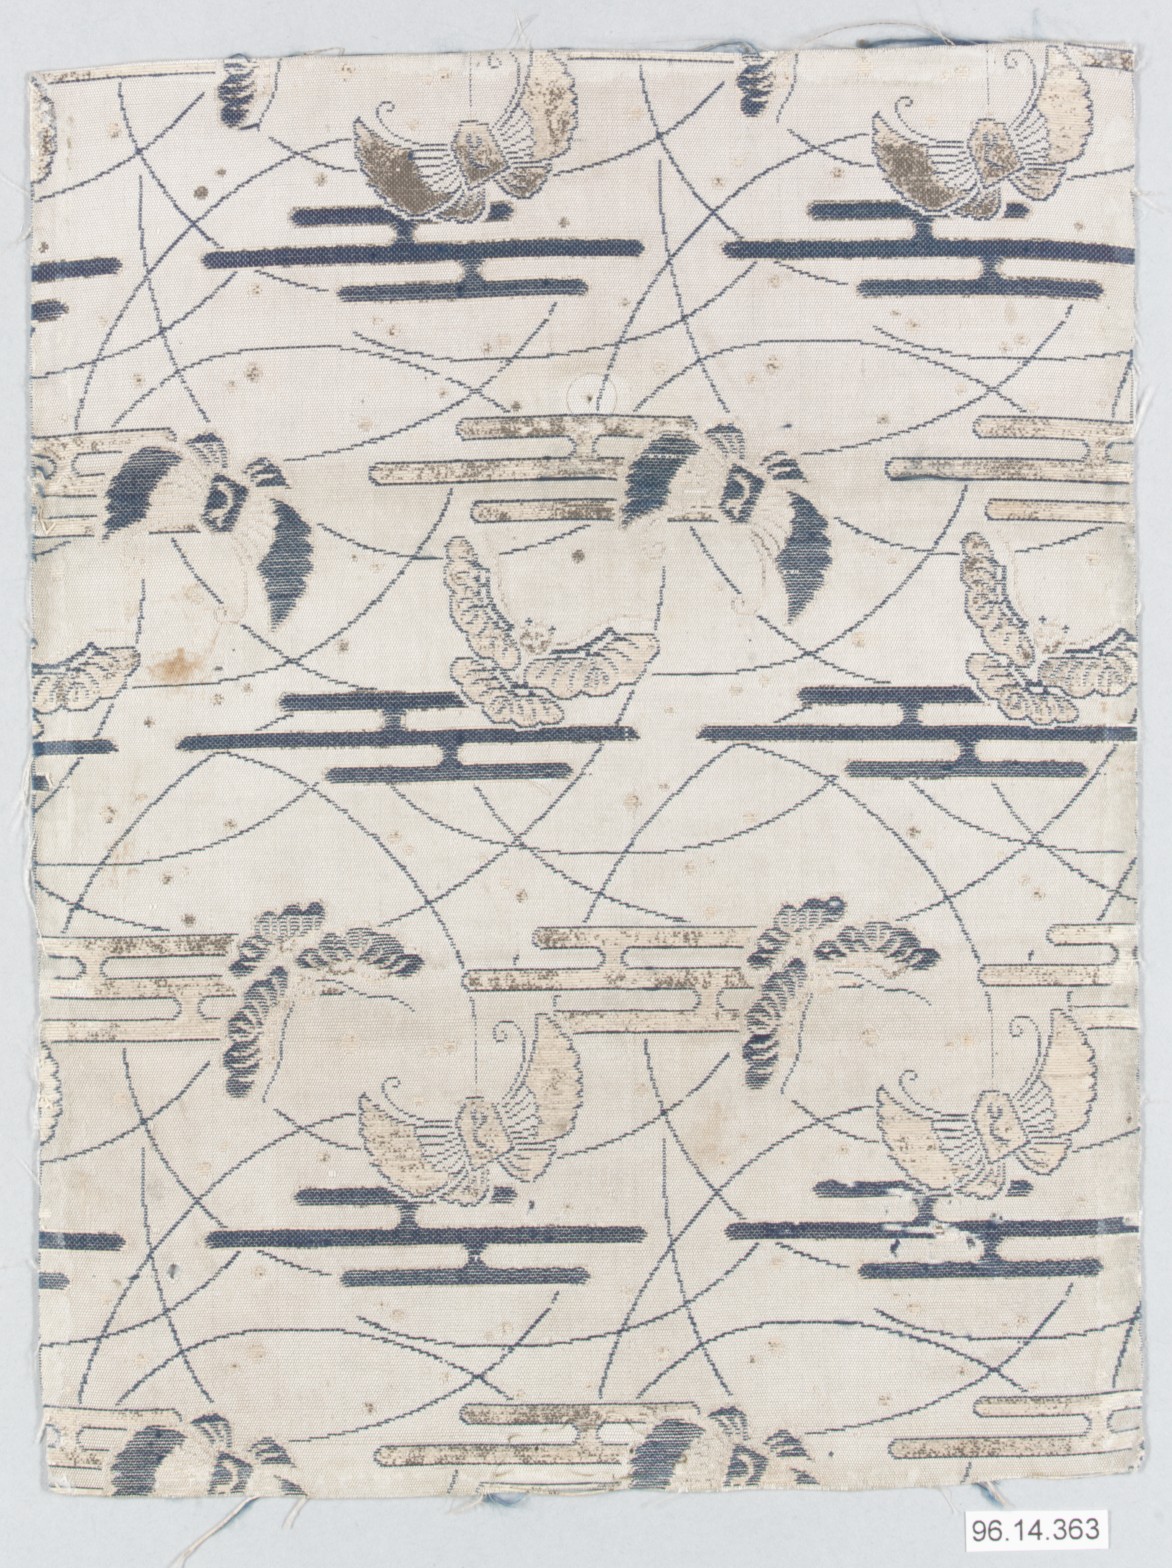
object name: piece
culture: japanese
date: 1701-1800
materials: metal thread, silk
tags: butterflies